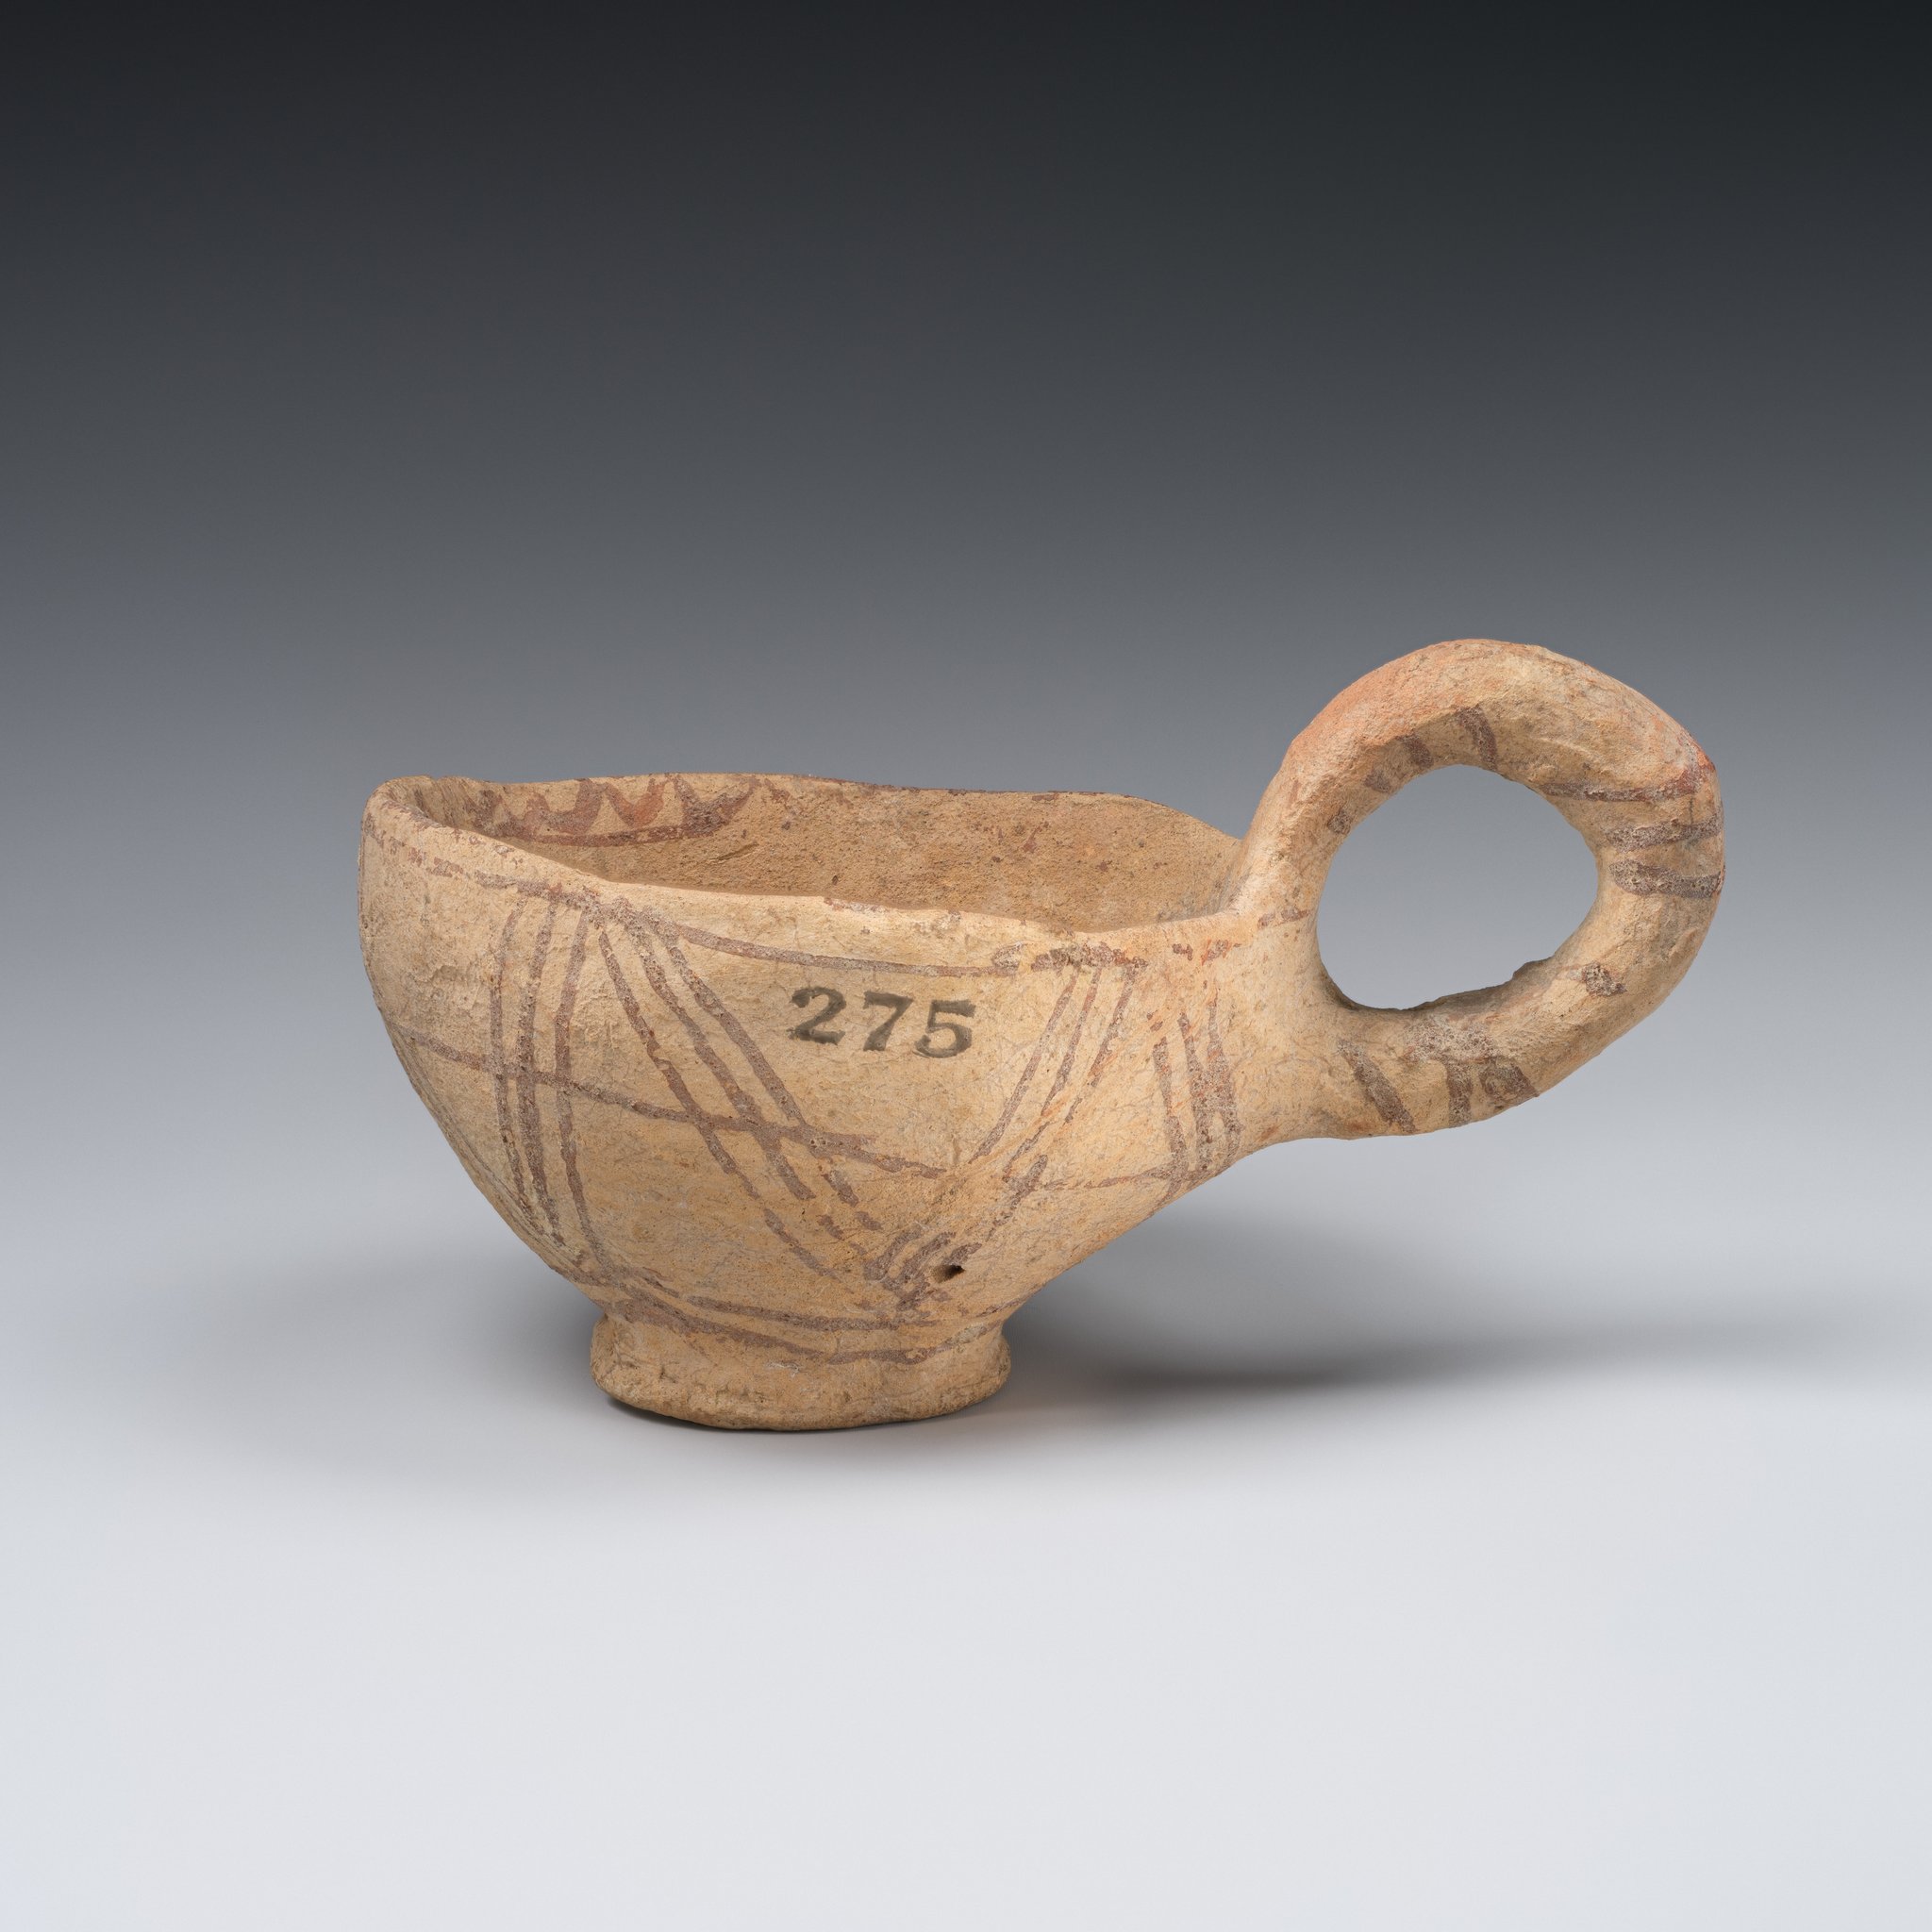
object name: cup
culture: cypriot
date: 3200-1050 BCE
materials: terracotta